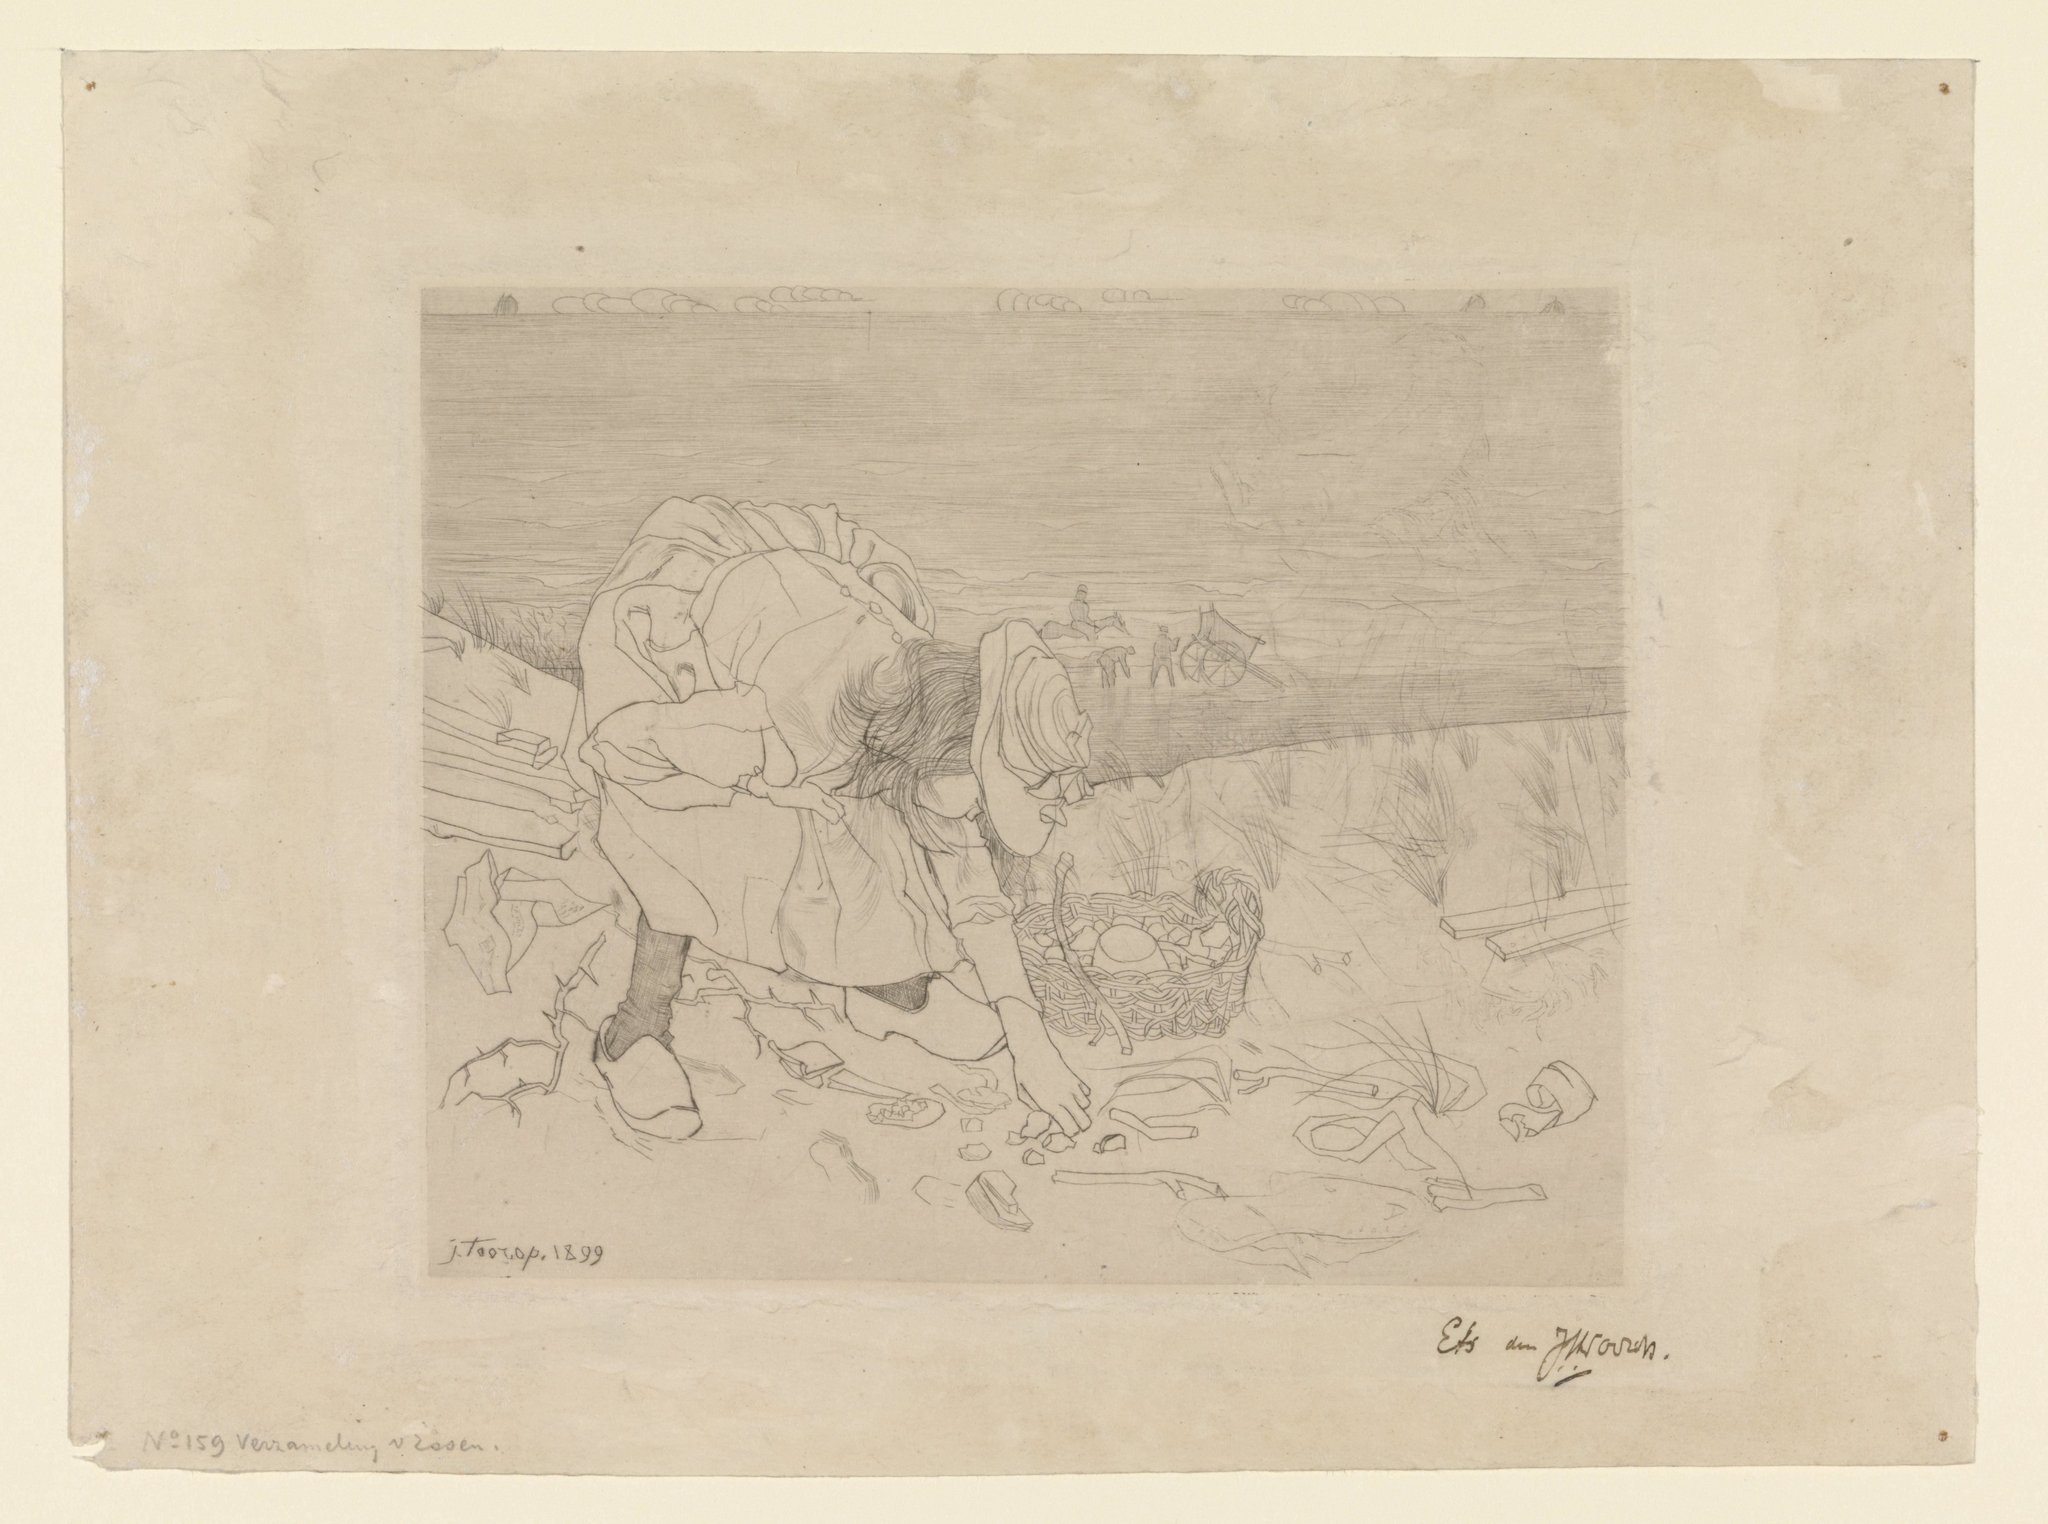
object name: print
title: Schelpen verzamelend meisje op het strand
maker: jan toorop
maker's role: draughtsman, painter, print maker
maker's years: 1858-1928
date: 1899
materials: paper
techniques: drypoint, intaglio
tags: beach (as place of recreation), girl (child between toddler and youth)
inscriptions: collector's mark: Lugt 2760, collector's mark: Lugt 2228